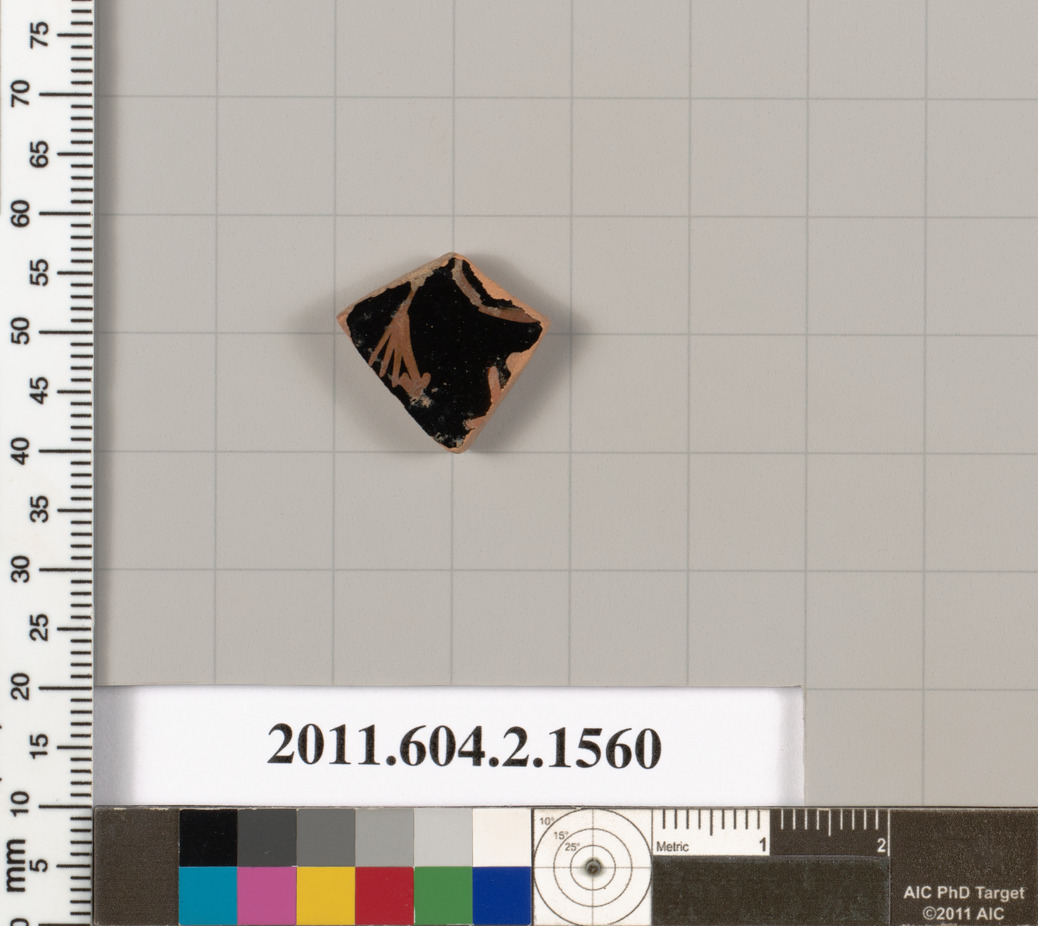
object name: skyphos fragment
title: Terracotta fragment of a skyphos (deep drinking cup)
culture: greek, attic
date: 490-470 BCE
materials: terracotta